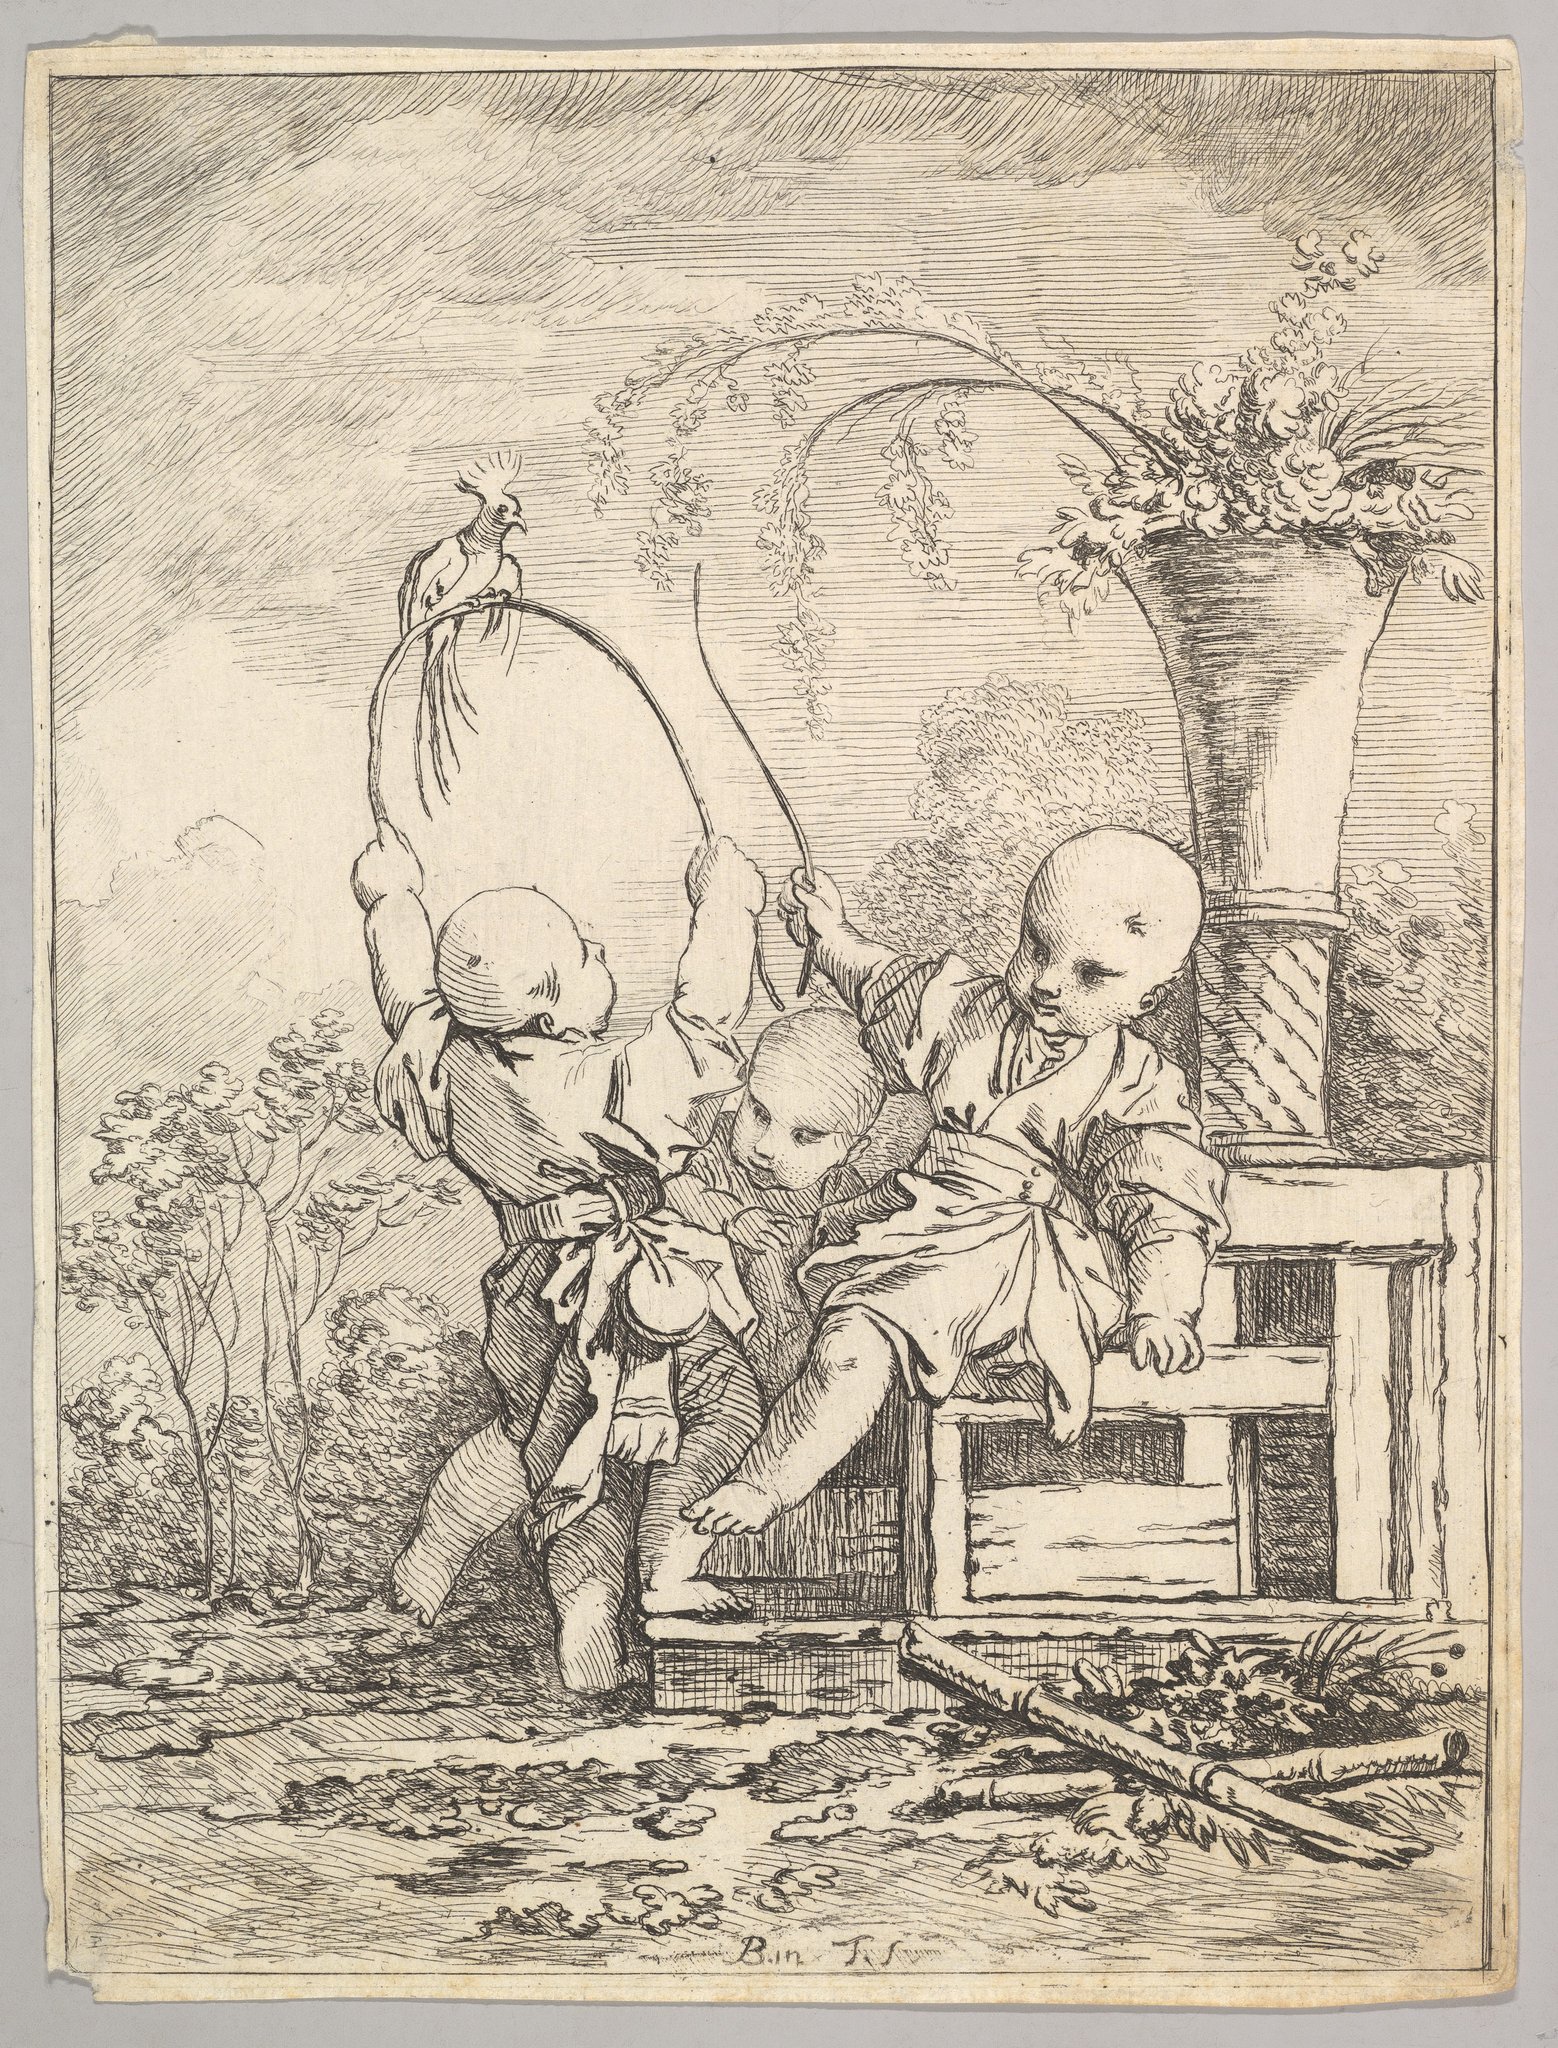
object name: print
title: Chinese Children Playing with a Parrot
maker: louis antoine crozat, baron de thiers, paris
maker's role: artist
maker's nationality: french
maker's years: 1699-1770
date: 1760-1770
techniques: etching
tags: boys,playing,parrots,flowers